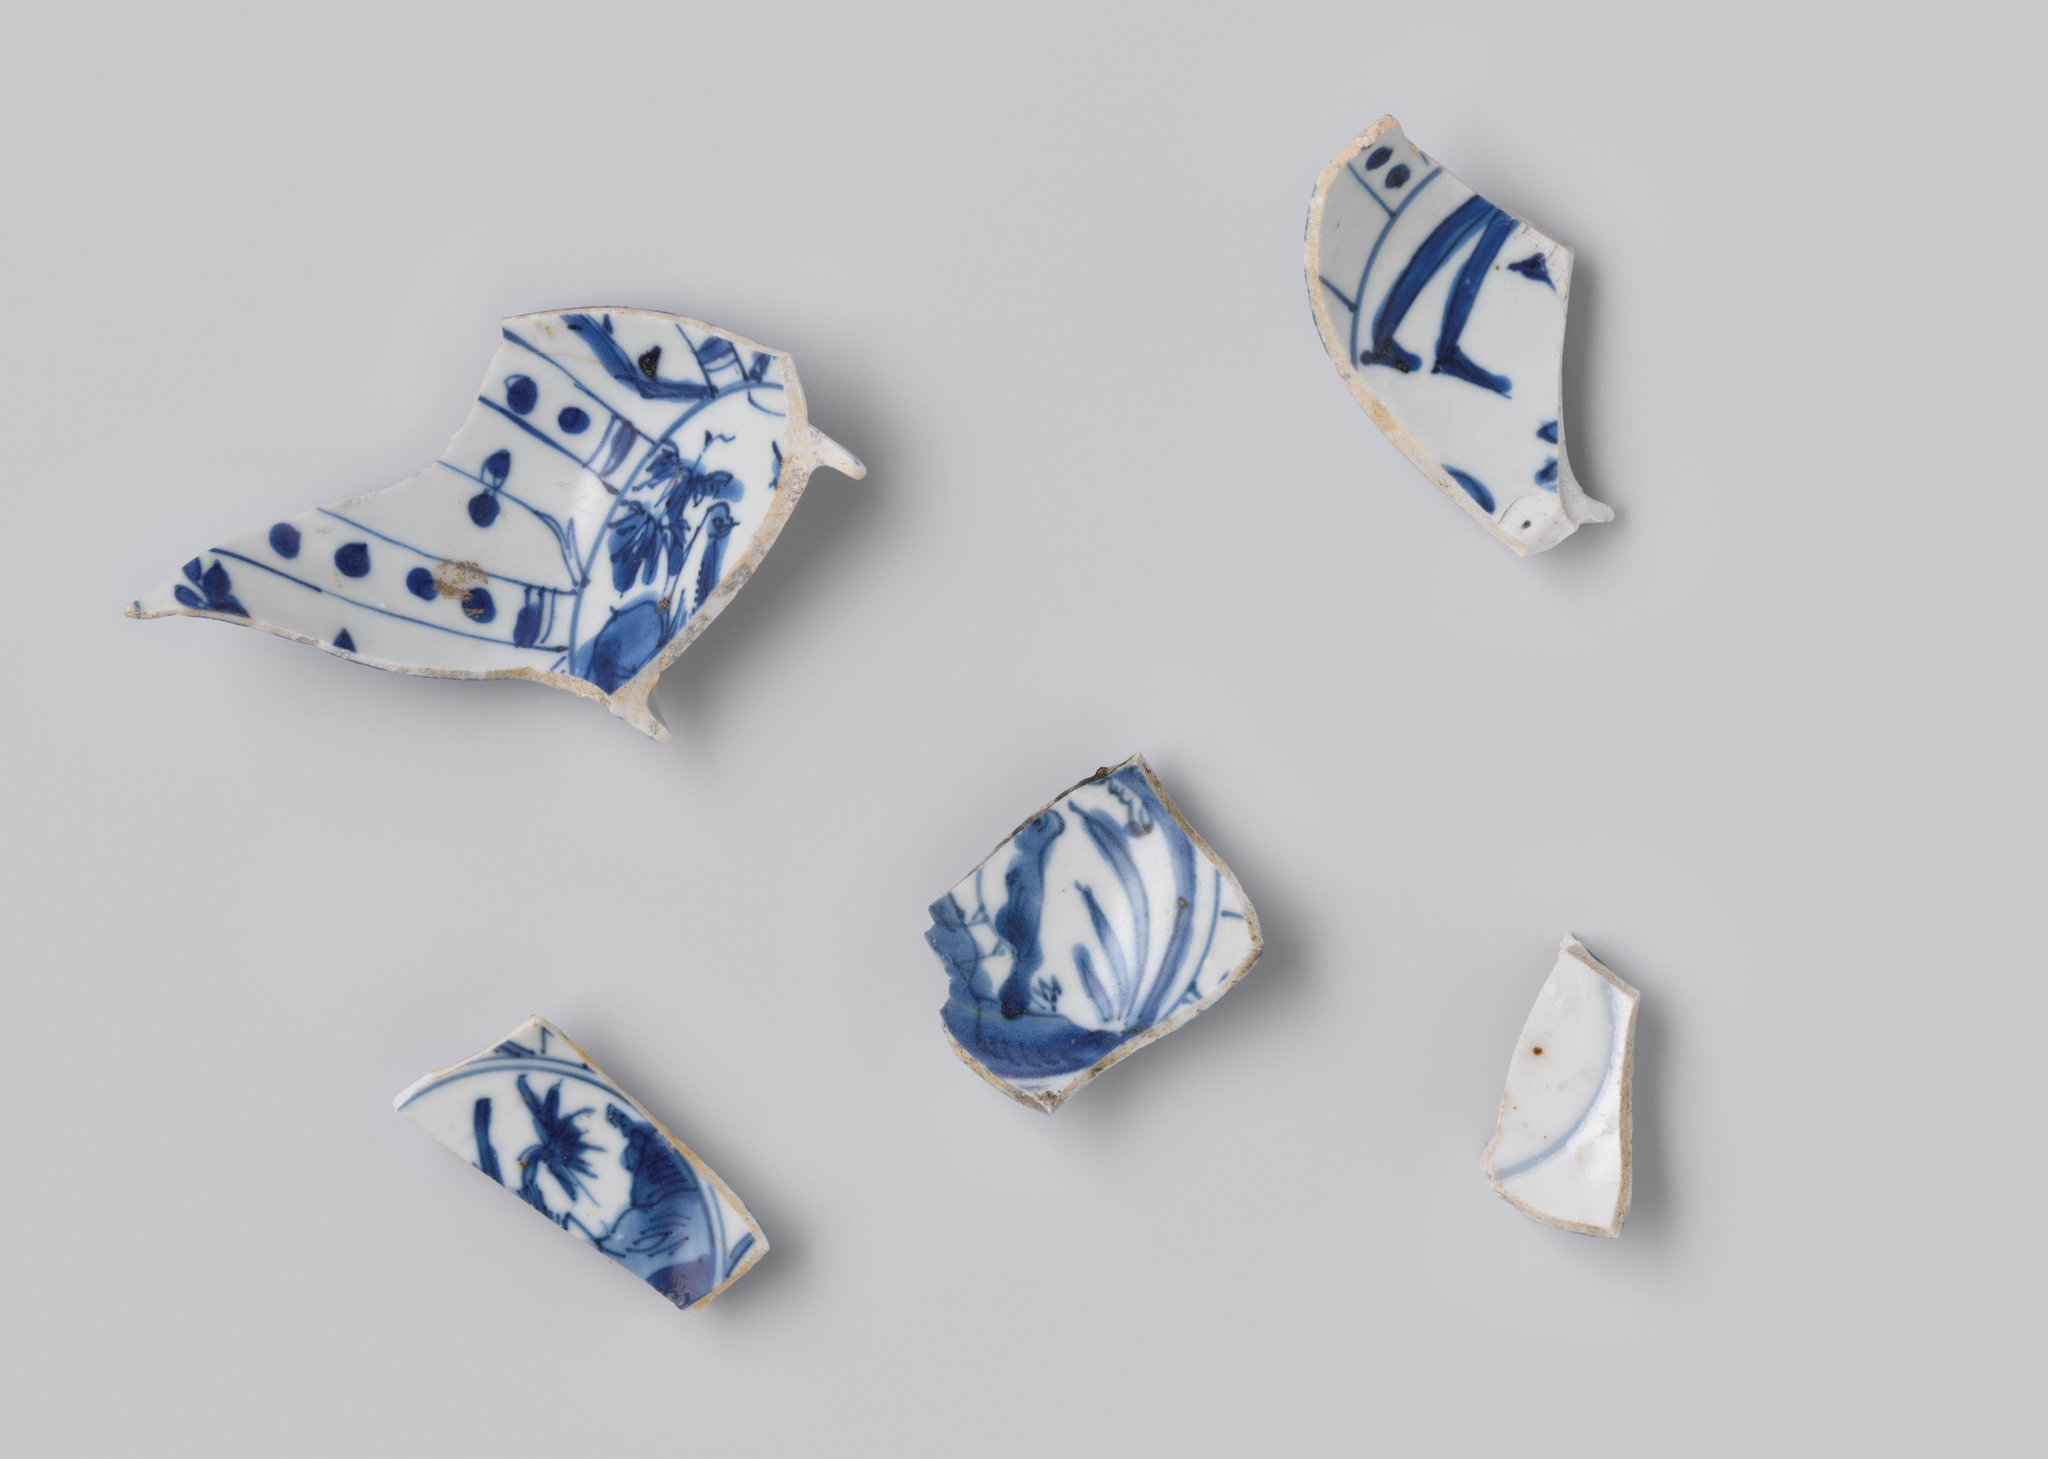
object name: kraaikop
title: Scherven van kraaikoppen uit V.O.C.-schip de 'Witte Leeuw'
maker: Anonymous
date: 1613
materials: bone china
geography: jingdezhen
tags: verenigde oostindische compagnie, sint-helena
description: Scherven van kraaikoppen uit V.O.C.-schip de 'Witte Leeuw'.